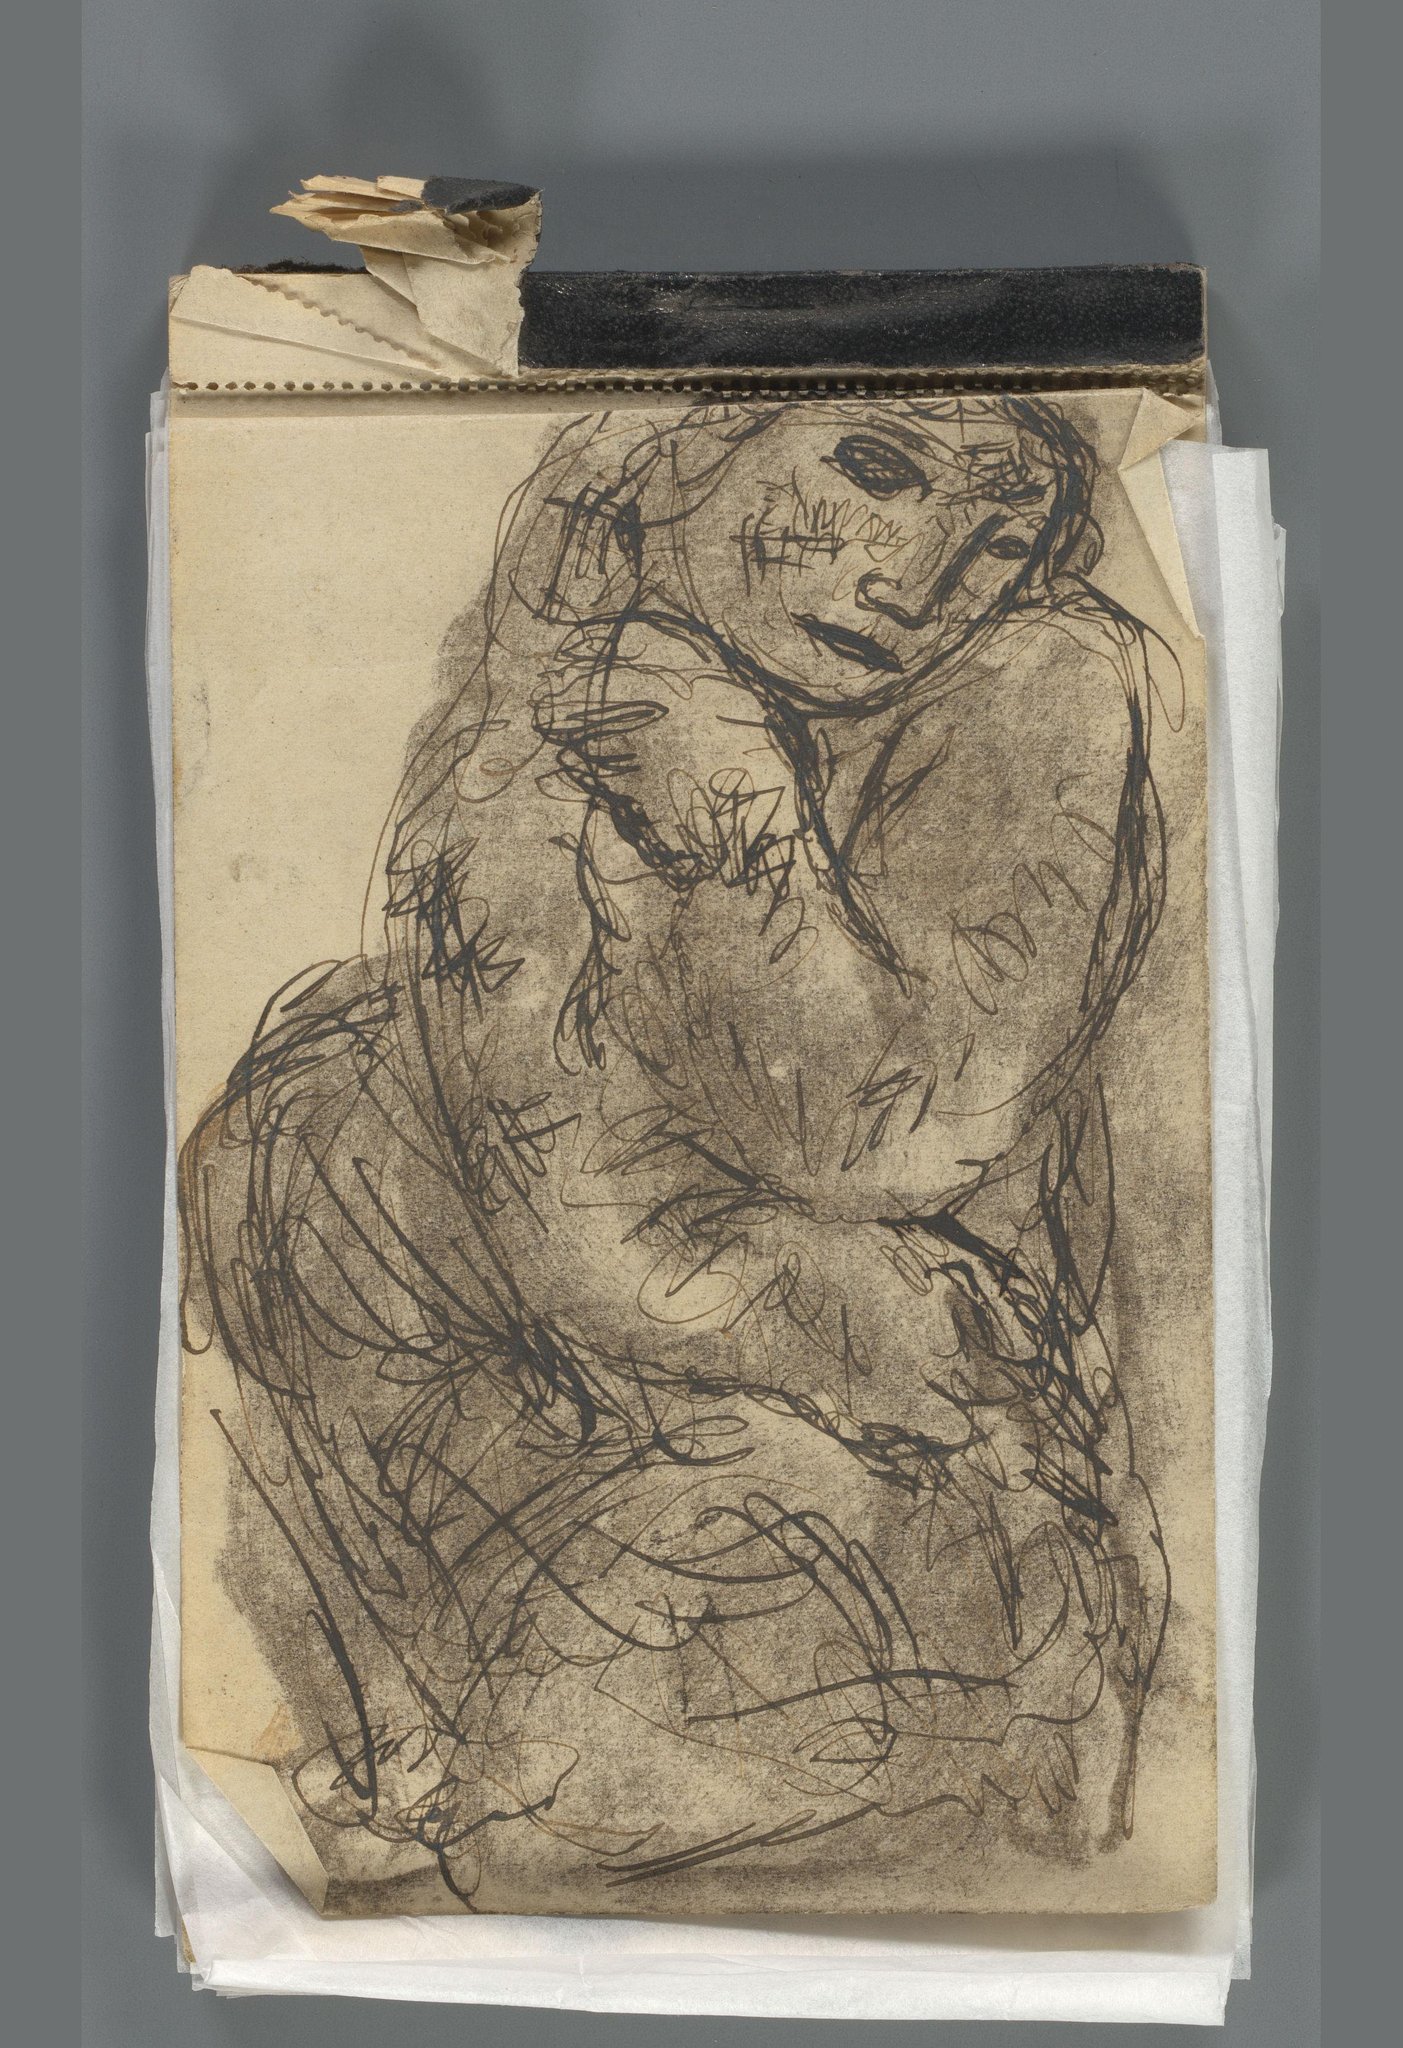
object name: sketchbook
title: Schetsboek Blaricum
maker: leo gestel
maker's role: draughtsman, print maker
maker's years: 1881-1941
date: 1931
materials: chalk, charcoal, gouache, ink, paper, pencil, watercolor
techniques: brush, drawing, pen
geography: blaricum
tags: woman (showing herself) undressed, quasi-nude, horse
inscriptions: inscription: ‘Bl 31’, workshop stamp: Lugt 1078a, inscription: ‘schetsboek 1931/ 50 teekeningen’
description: Schetsboek met tekeningen van paarden, naakten en koppen; zonder voorkant kaft.